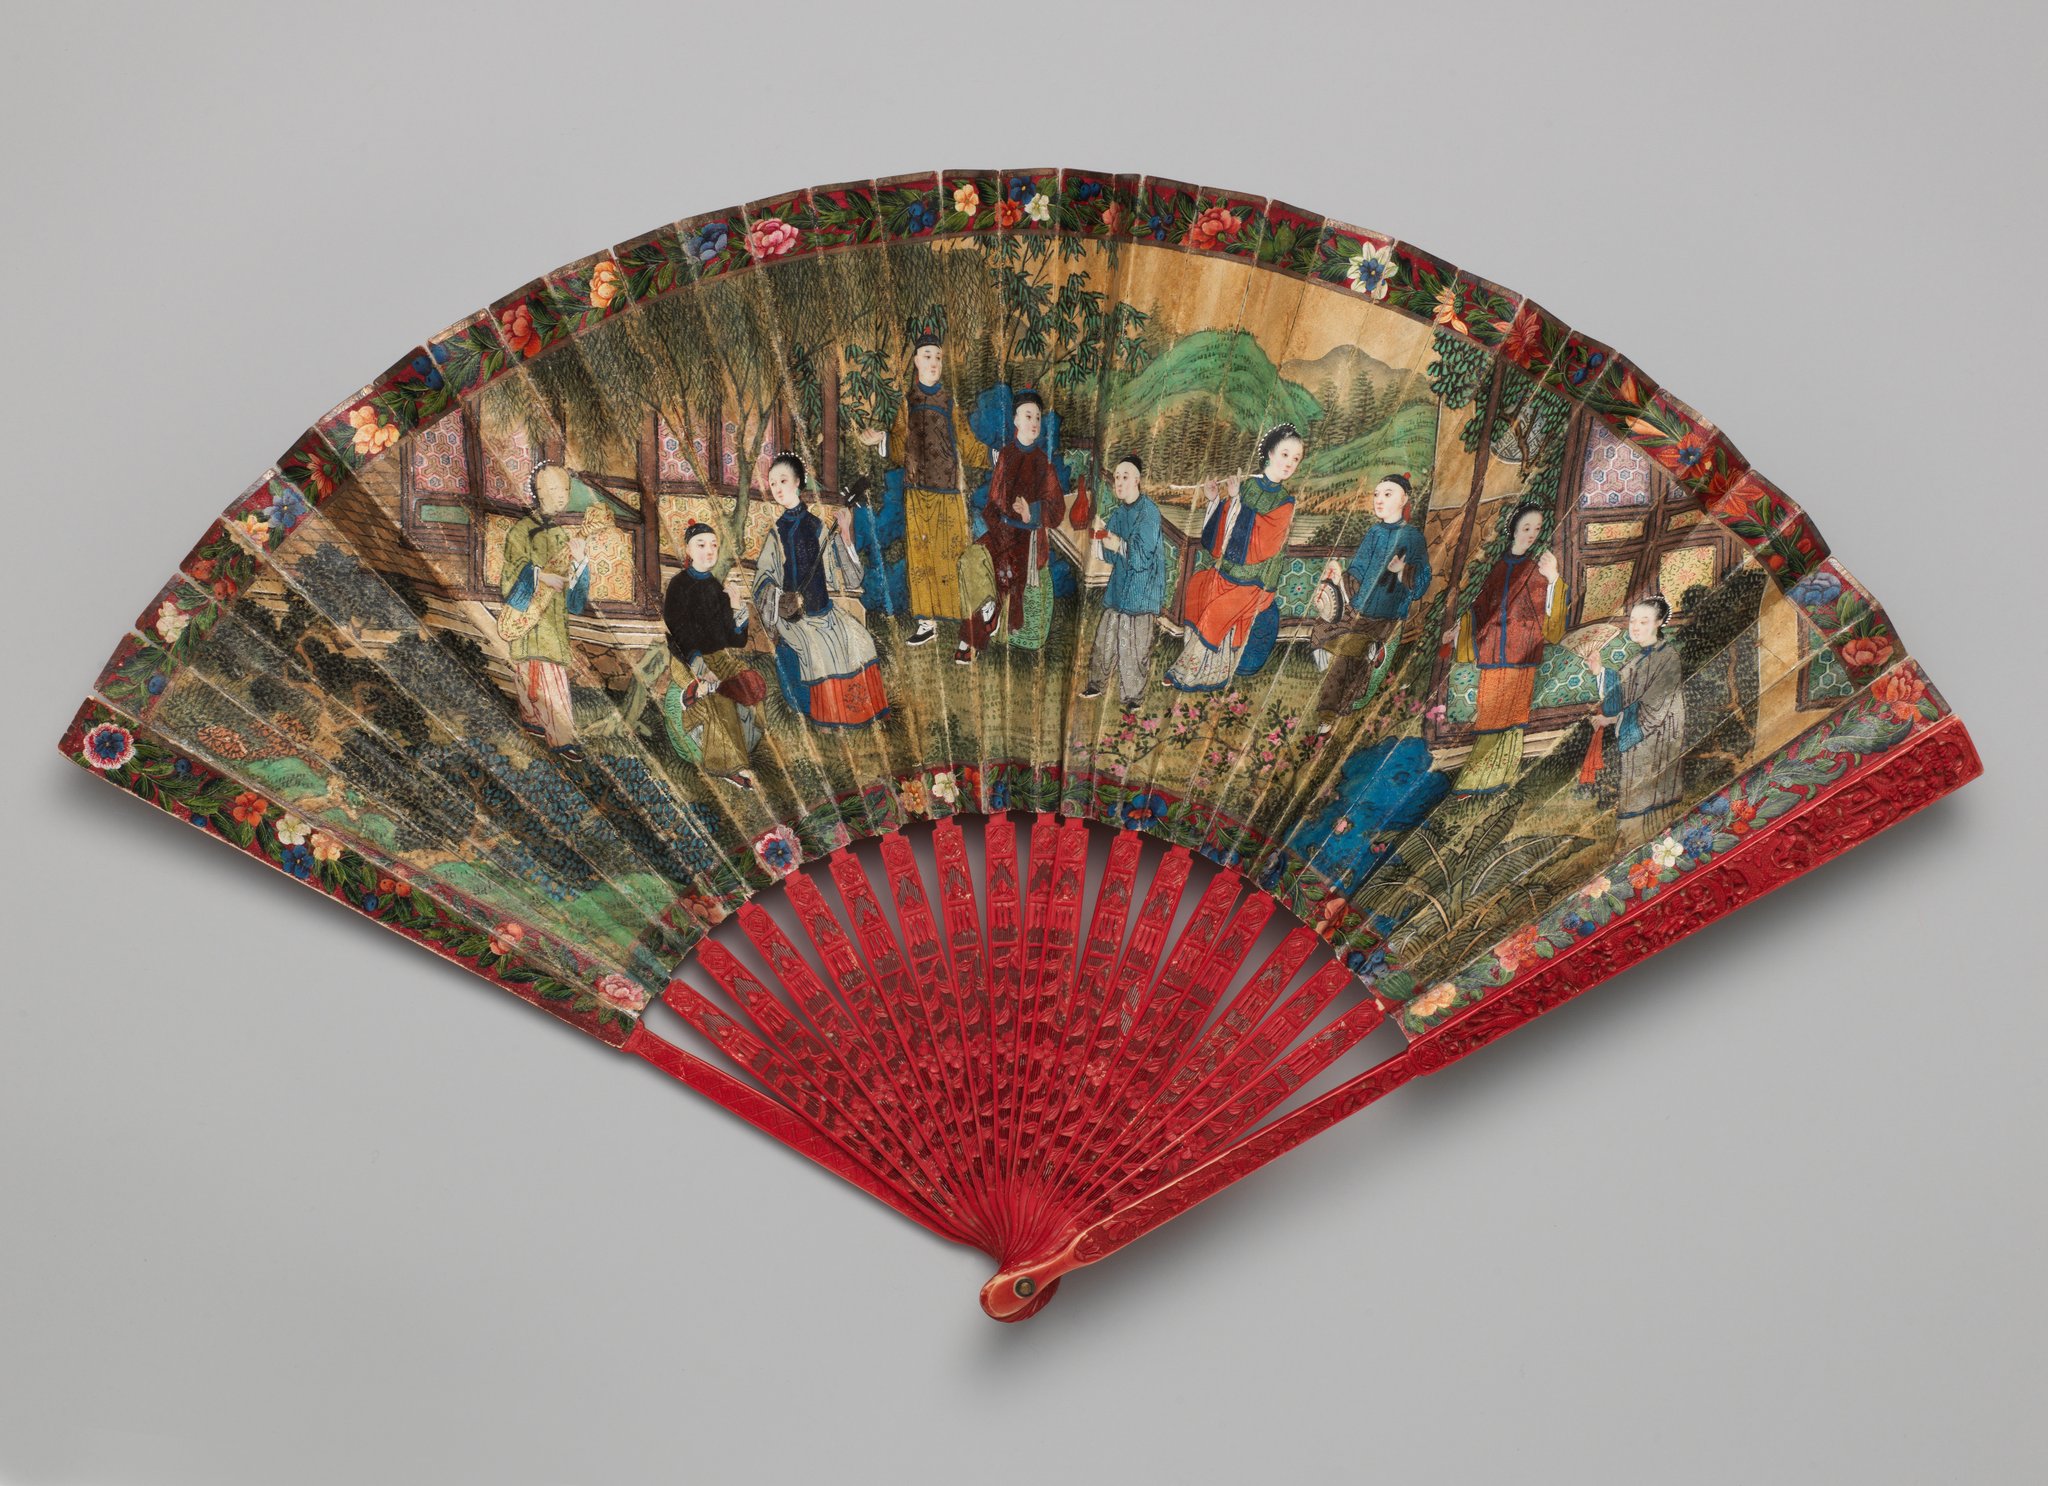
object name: fan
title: Folding Fan with Scene of Figures in a Courtyard Garden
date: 1801-1900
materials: bamboo, paper, silk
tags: musical instruments,birds,men,women